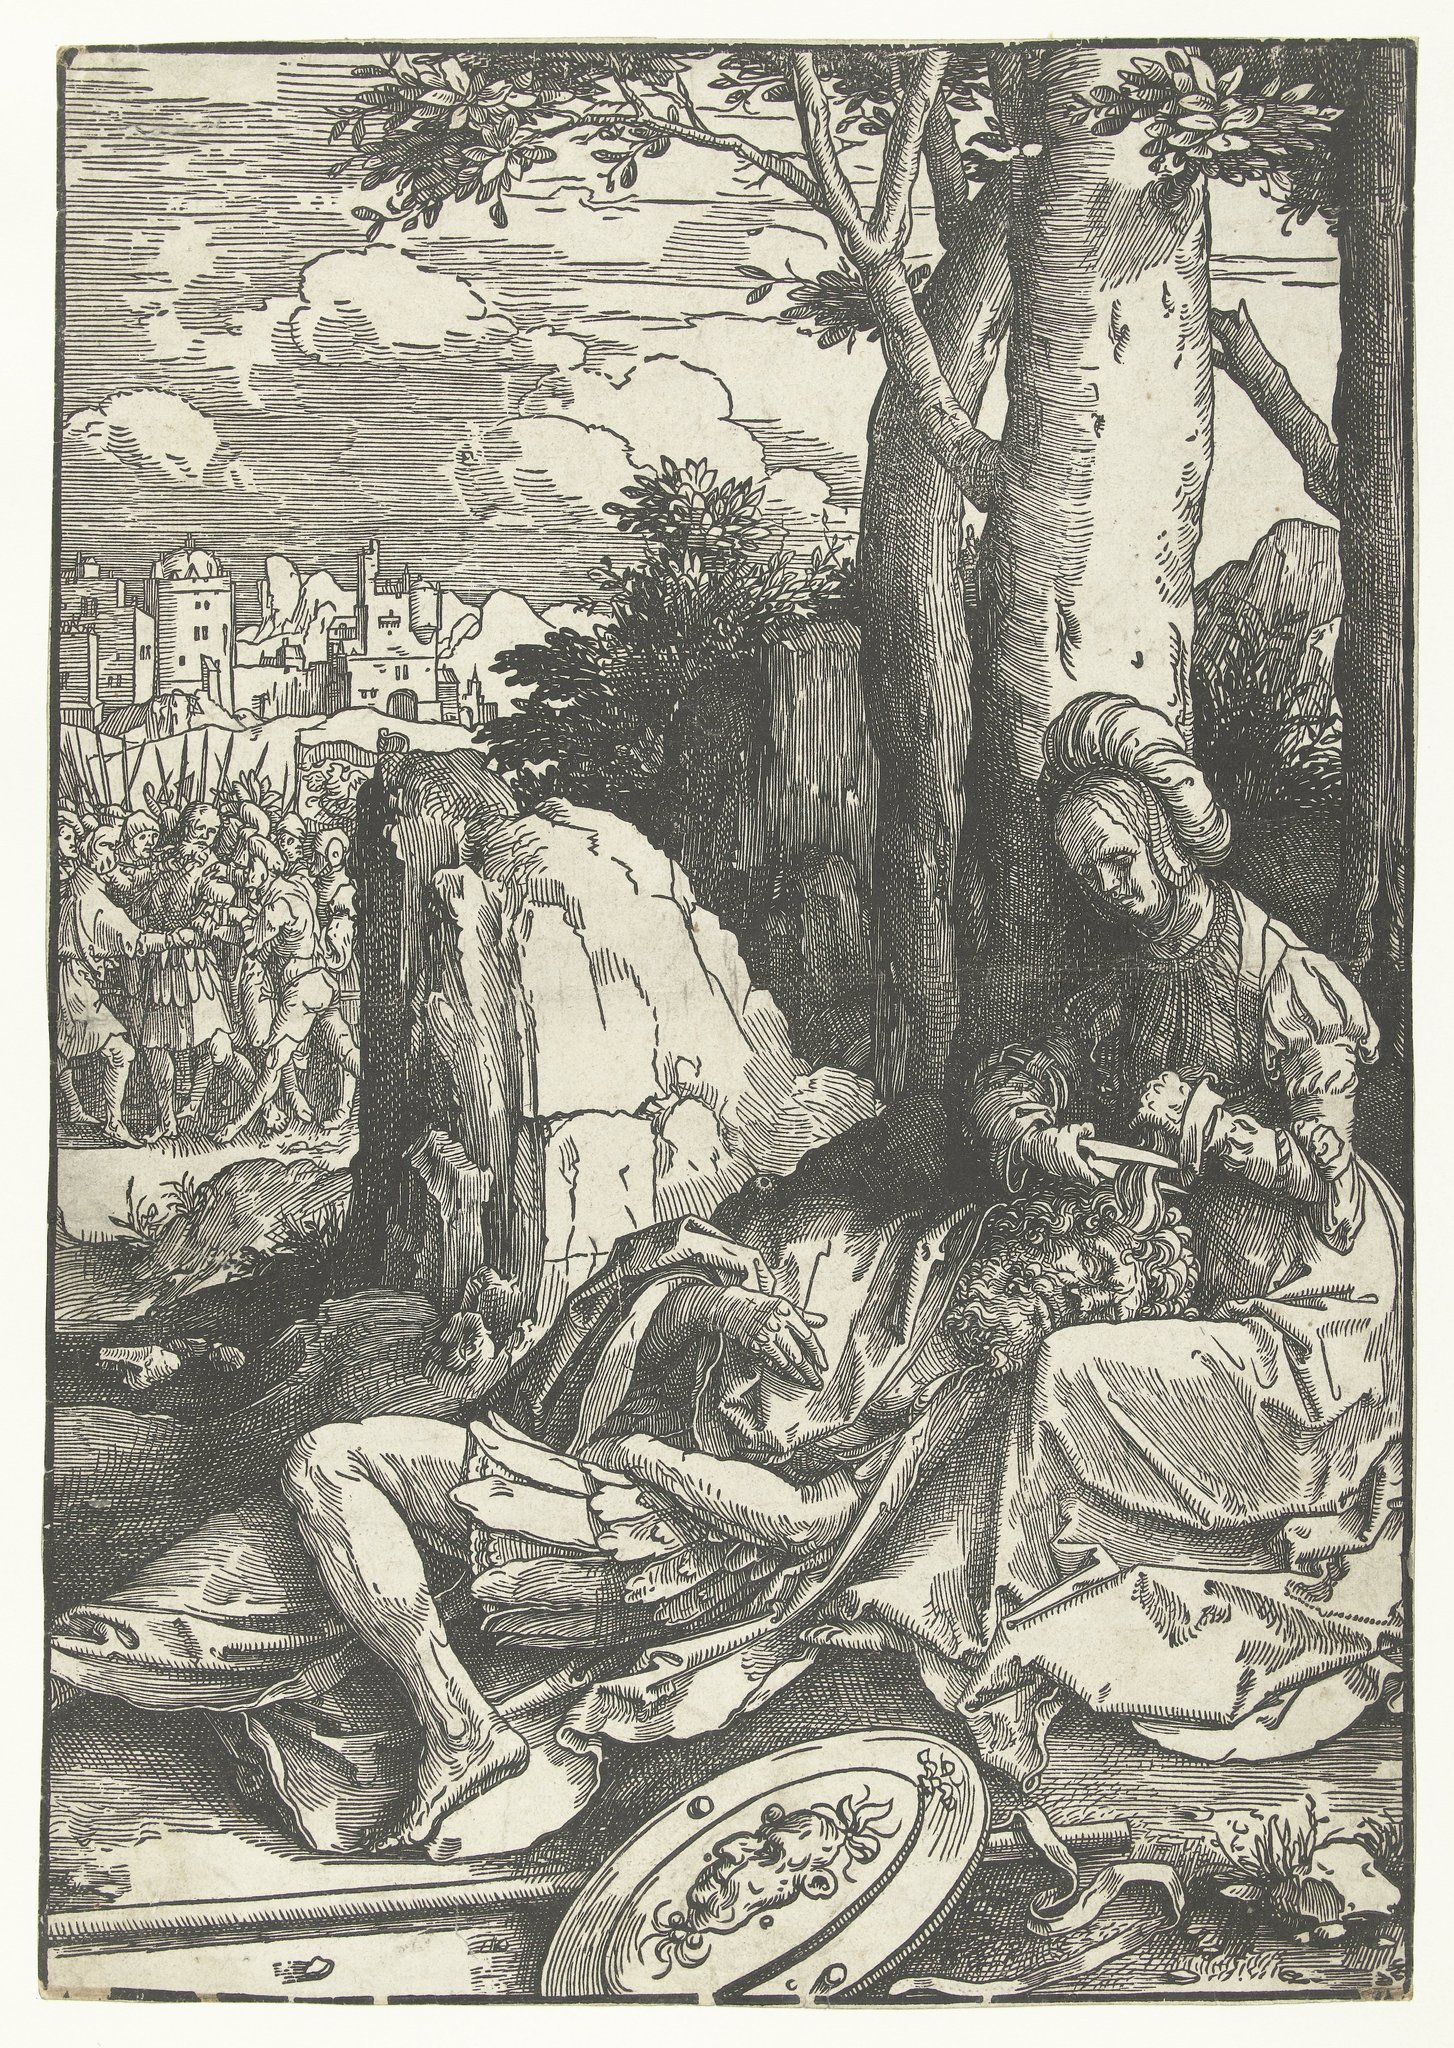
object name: print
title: Grote serie Vrouwenlisten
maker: lucas van leyden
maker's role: draughtsman, painter, print maker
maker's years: 1494-1533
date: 1514-1516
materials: paper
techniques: woodcut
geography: low countries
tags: samson's hairlocks are cut off by delilah, samson wakes up and finds his hair and strength gone; he is taken prisoner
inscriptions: collector's mark: Lugt 240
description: Delila knipt haren af van de slapende Simson. Op de achtergrond Simson die door de Filistijnen gevangen wordt genomen.